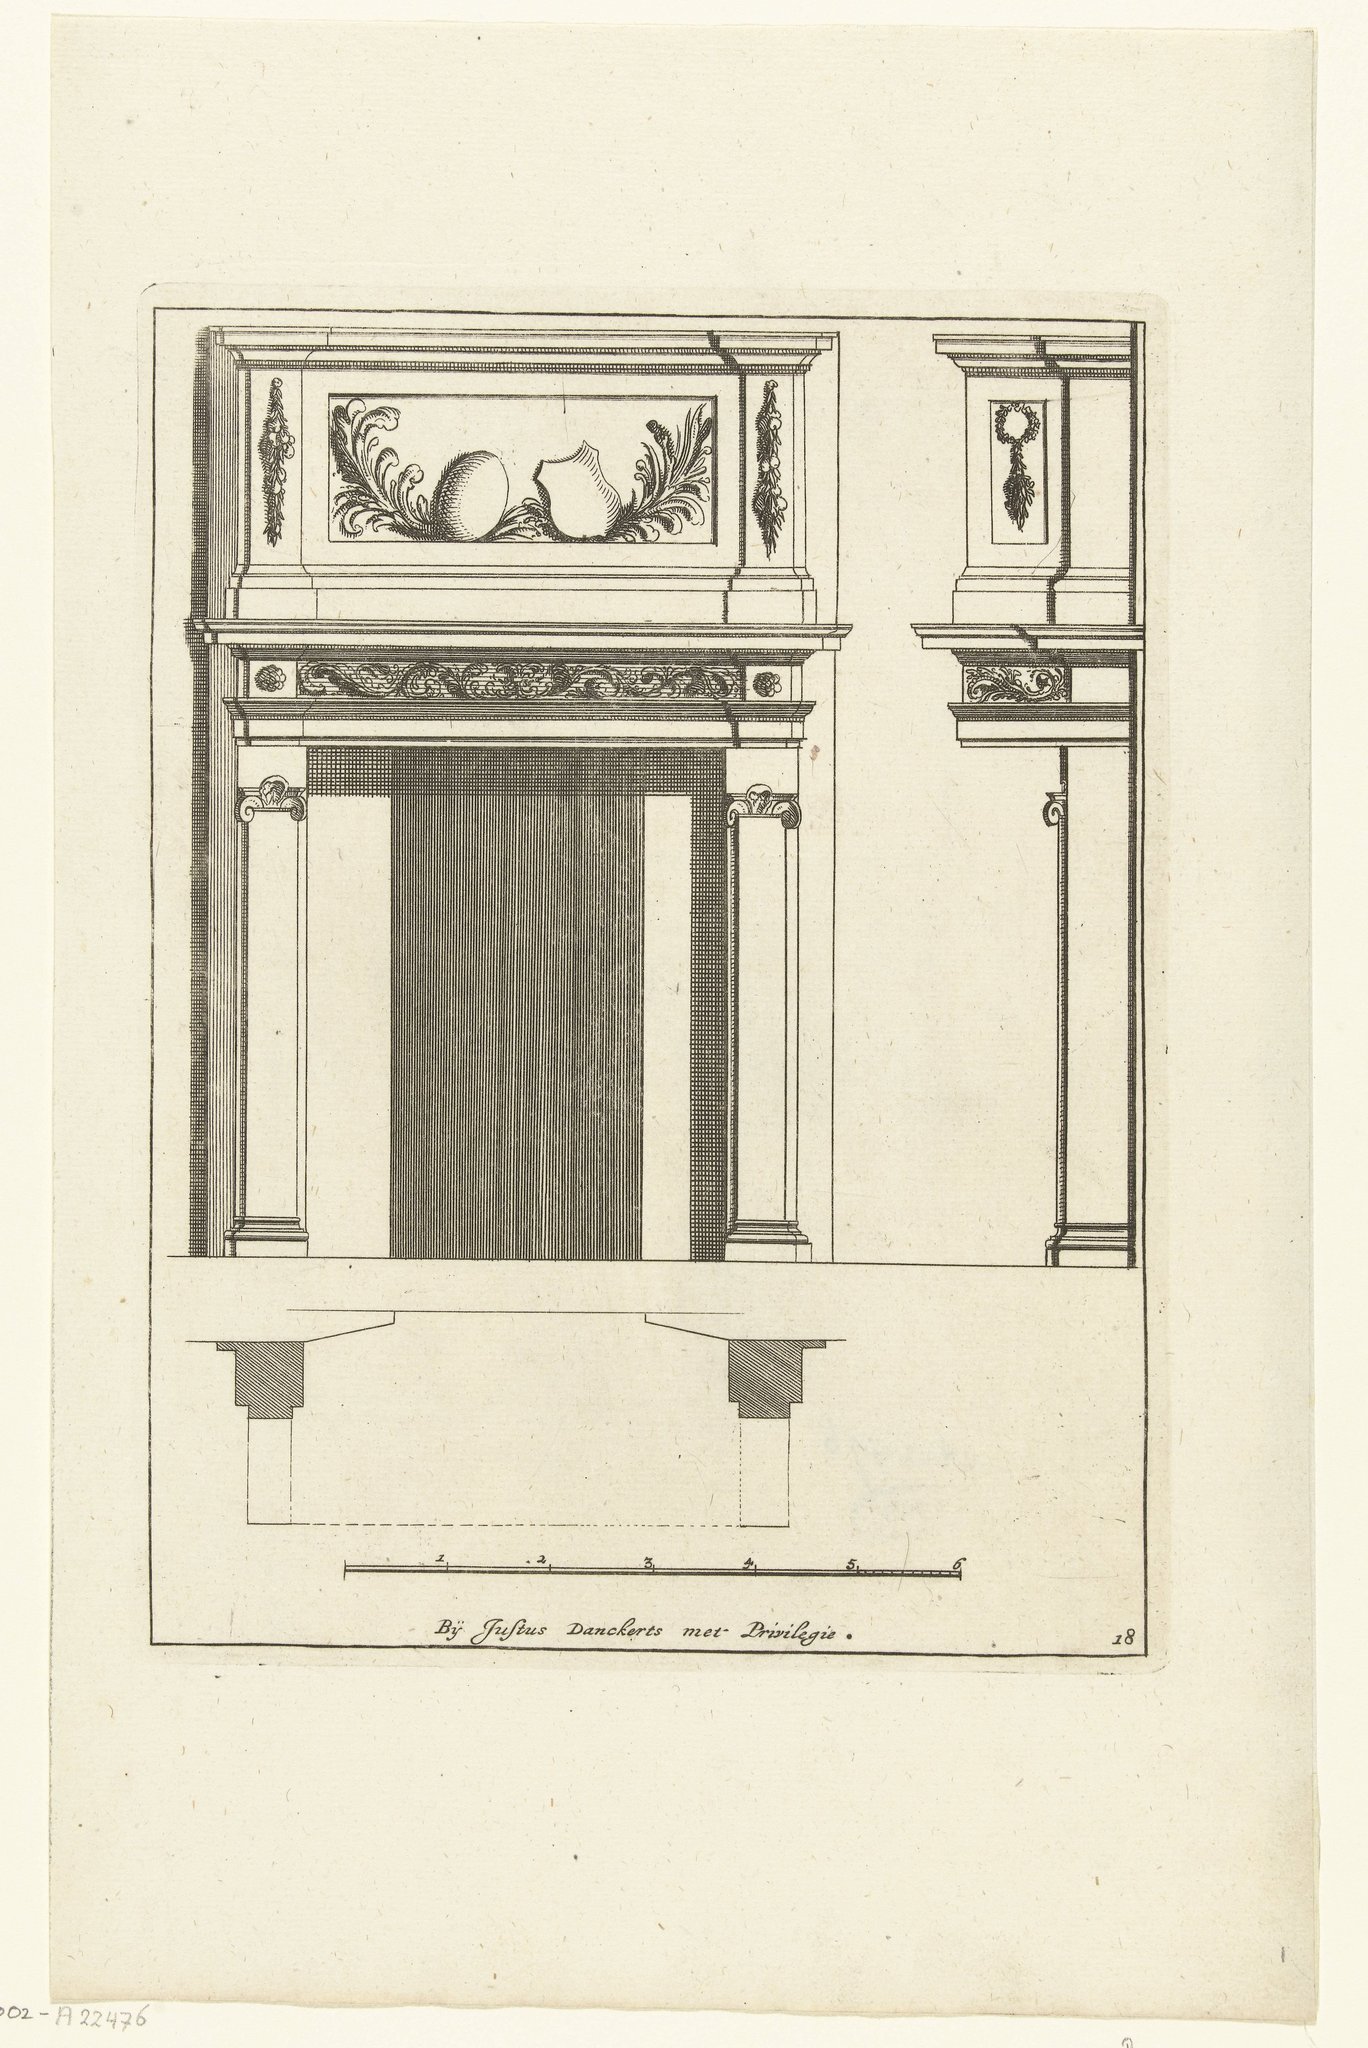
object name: print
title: Onderboezem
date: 1675-1686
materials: paper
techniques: etching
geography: netherlands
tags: chimney-piece, mantelpiece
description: Opstand, plan en zijopstand. Het tablet van de hoge schoorsteenboezem wordt ondersteund door Ionische pilasters.